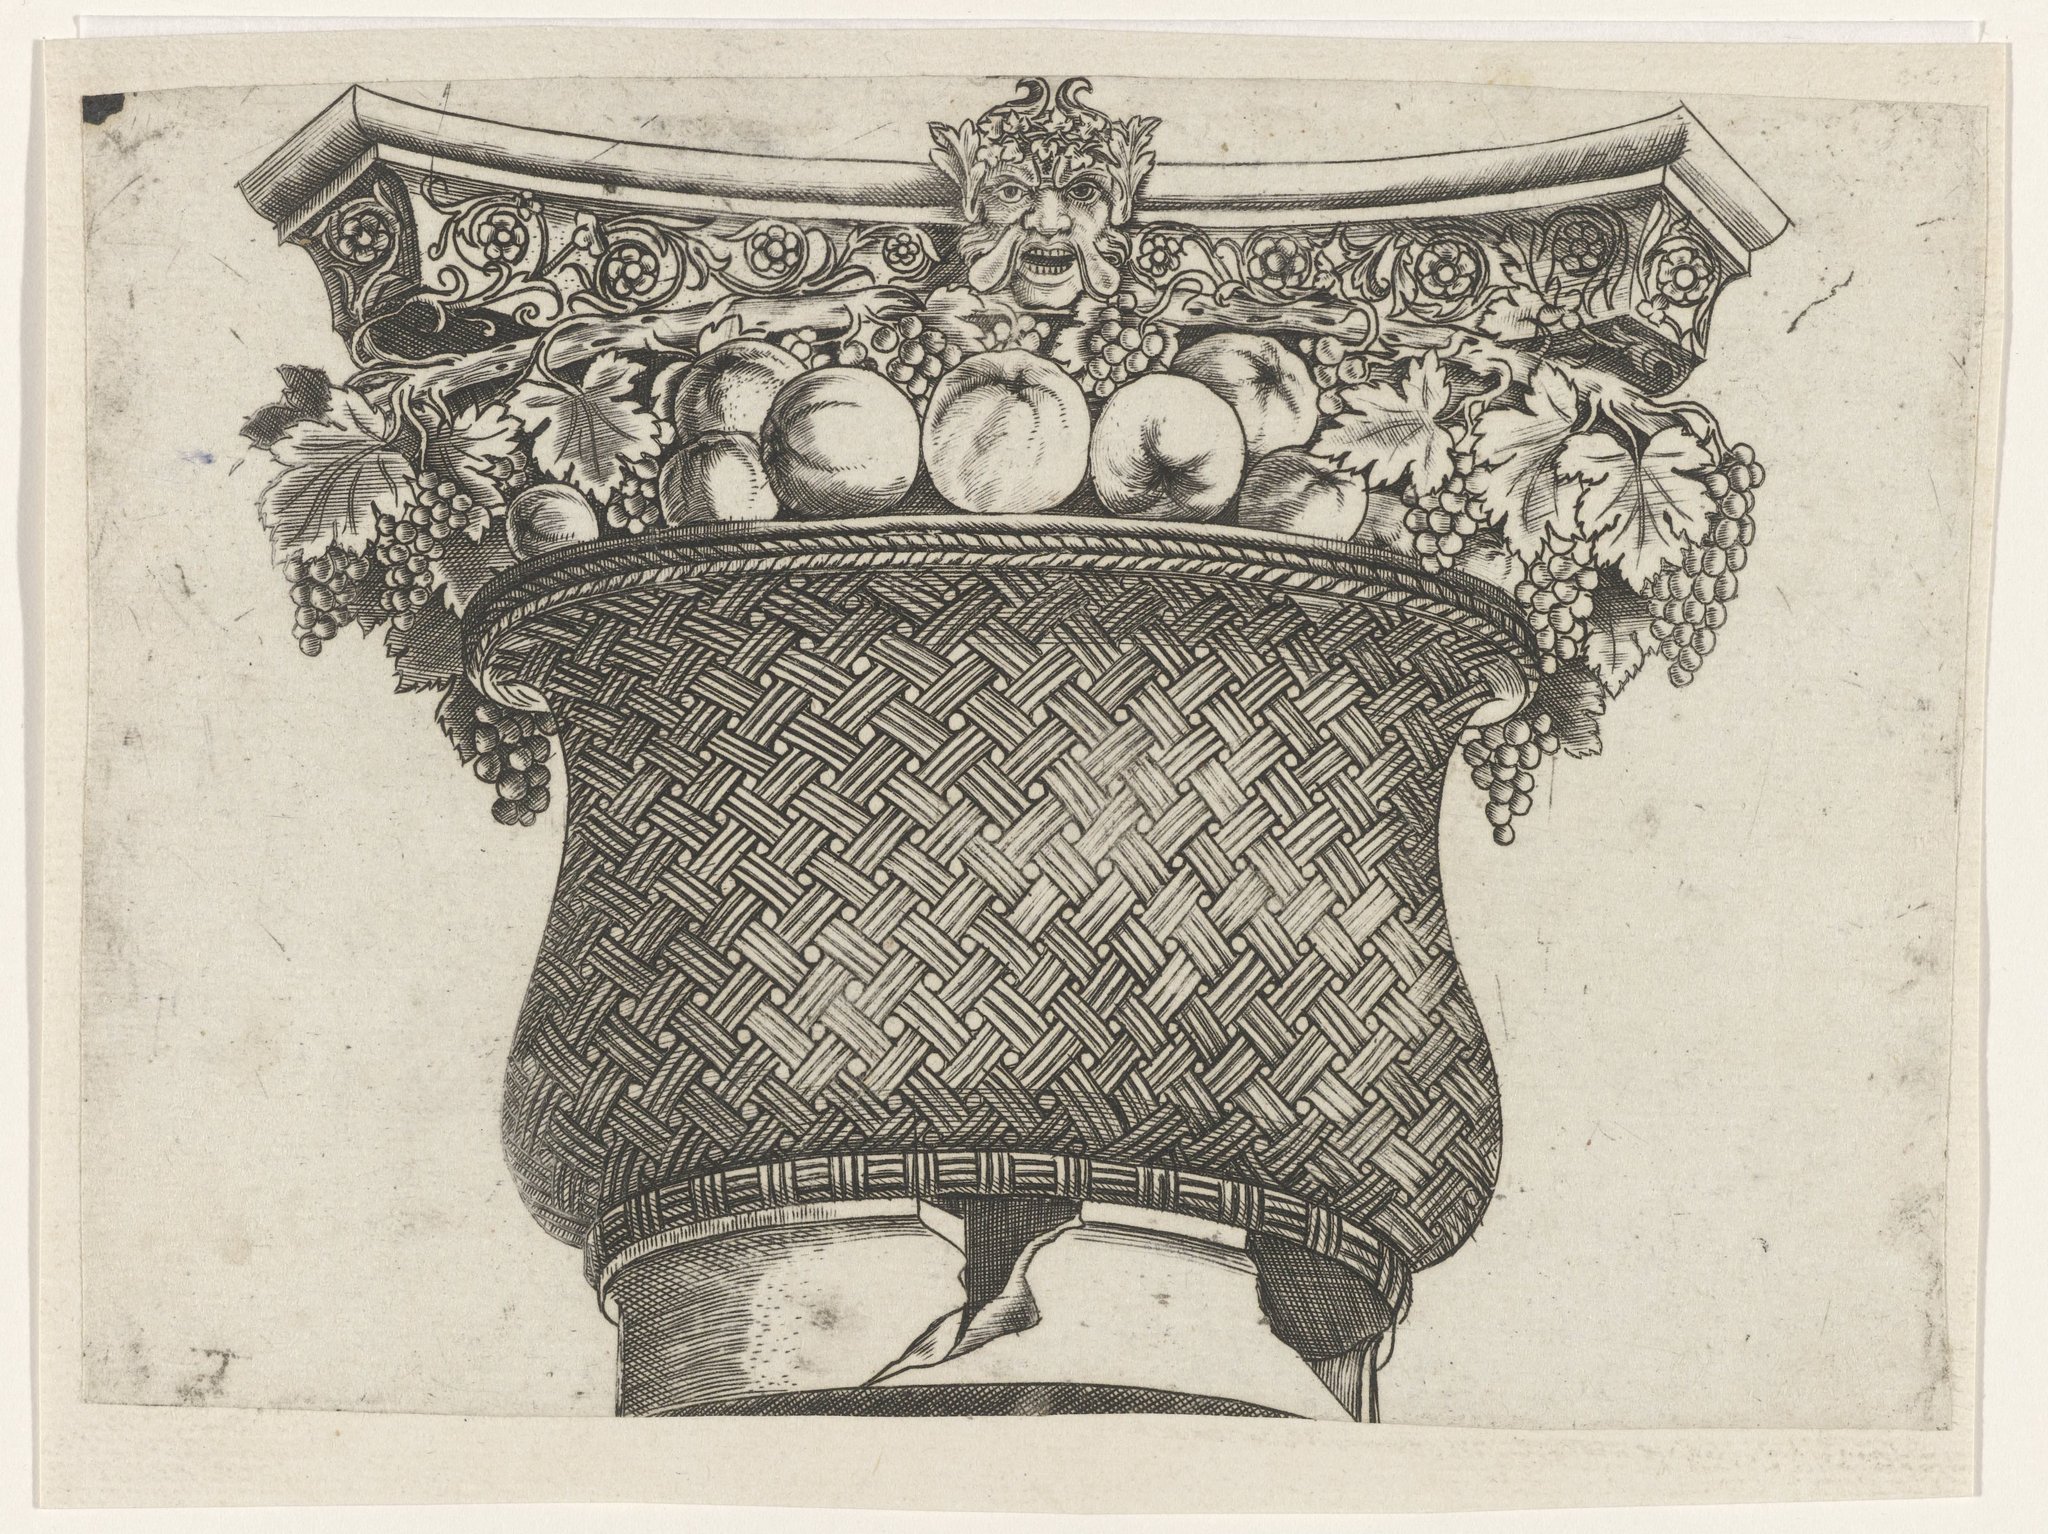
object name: print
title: Kapiteel met vlechtwerk en vruchten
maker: monogrammist ga met de voetangel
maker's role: print maker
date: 1530-1540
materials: paper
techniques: engraving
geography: italy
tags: ornament derived from architectural details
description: Kapiteel met vlechtwerk met daarboven vrucht en een satyrkop.